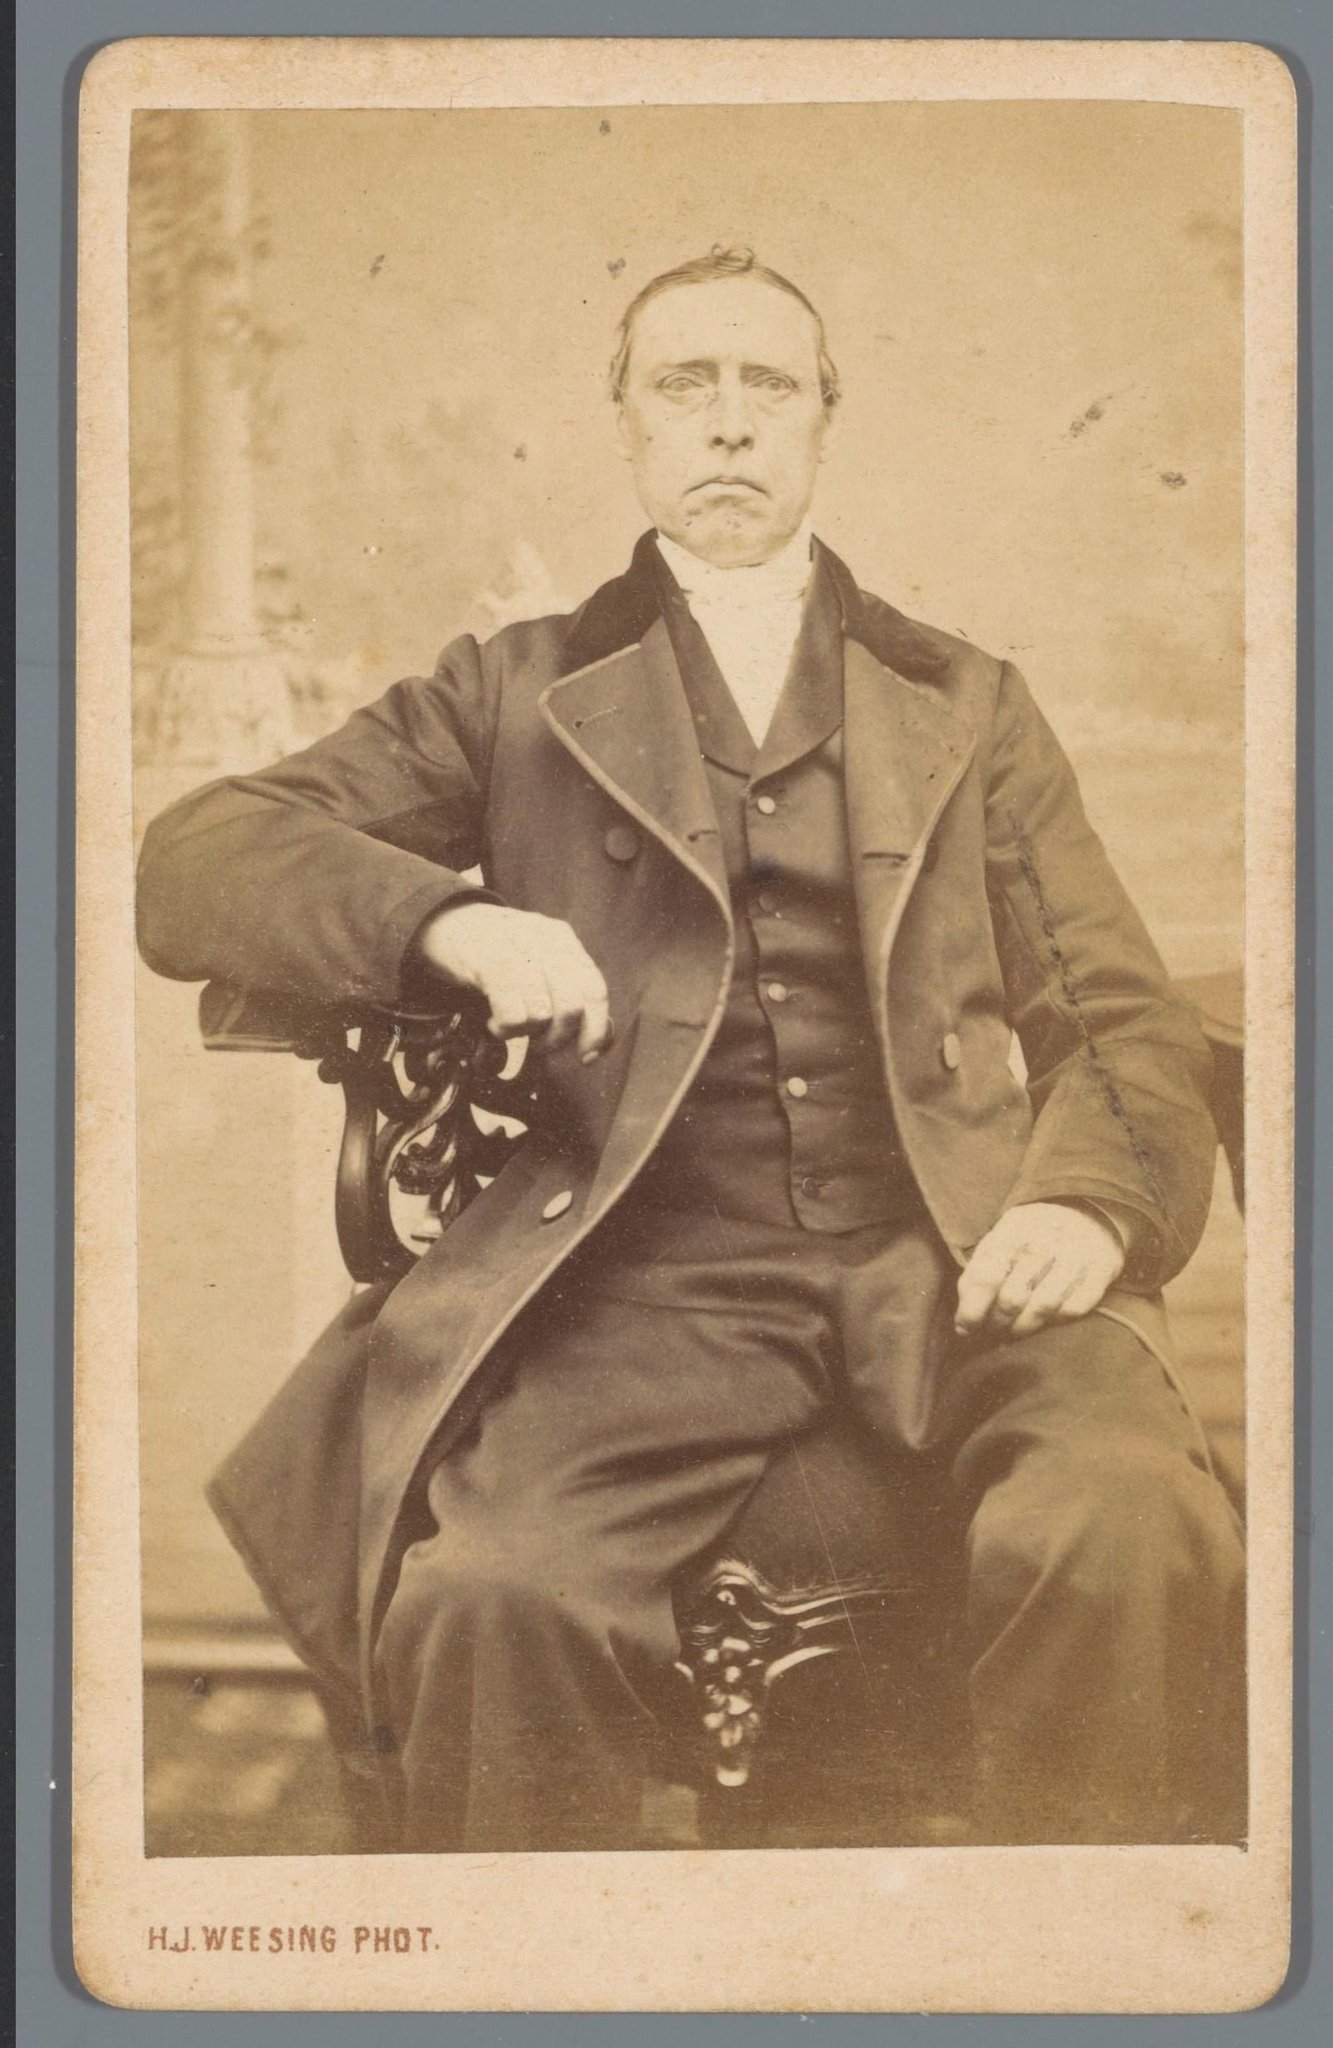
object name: photograph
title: Portret van een onbekende man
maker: hermanus jodocus weesing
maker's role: fotograaf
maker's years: 1844-1910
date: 1868-1900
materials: cardboard, paper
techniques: albumen print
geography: amsterdam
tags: adult man, anonymous historical person portrayed, amsterdam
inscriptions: inscription: ‘H.J. Weesing/ Photograaf/ Binnen Brouwerstraat T.T.220./ Amsterdam.’, monogram: ‘HJW’, inscription: ‘H.J. Weesing phot.’